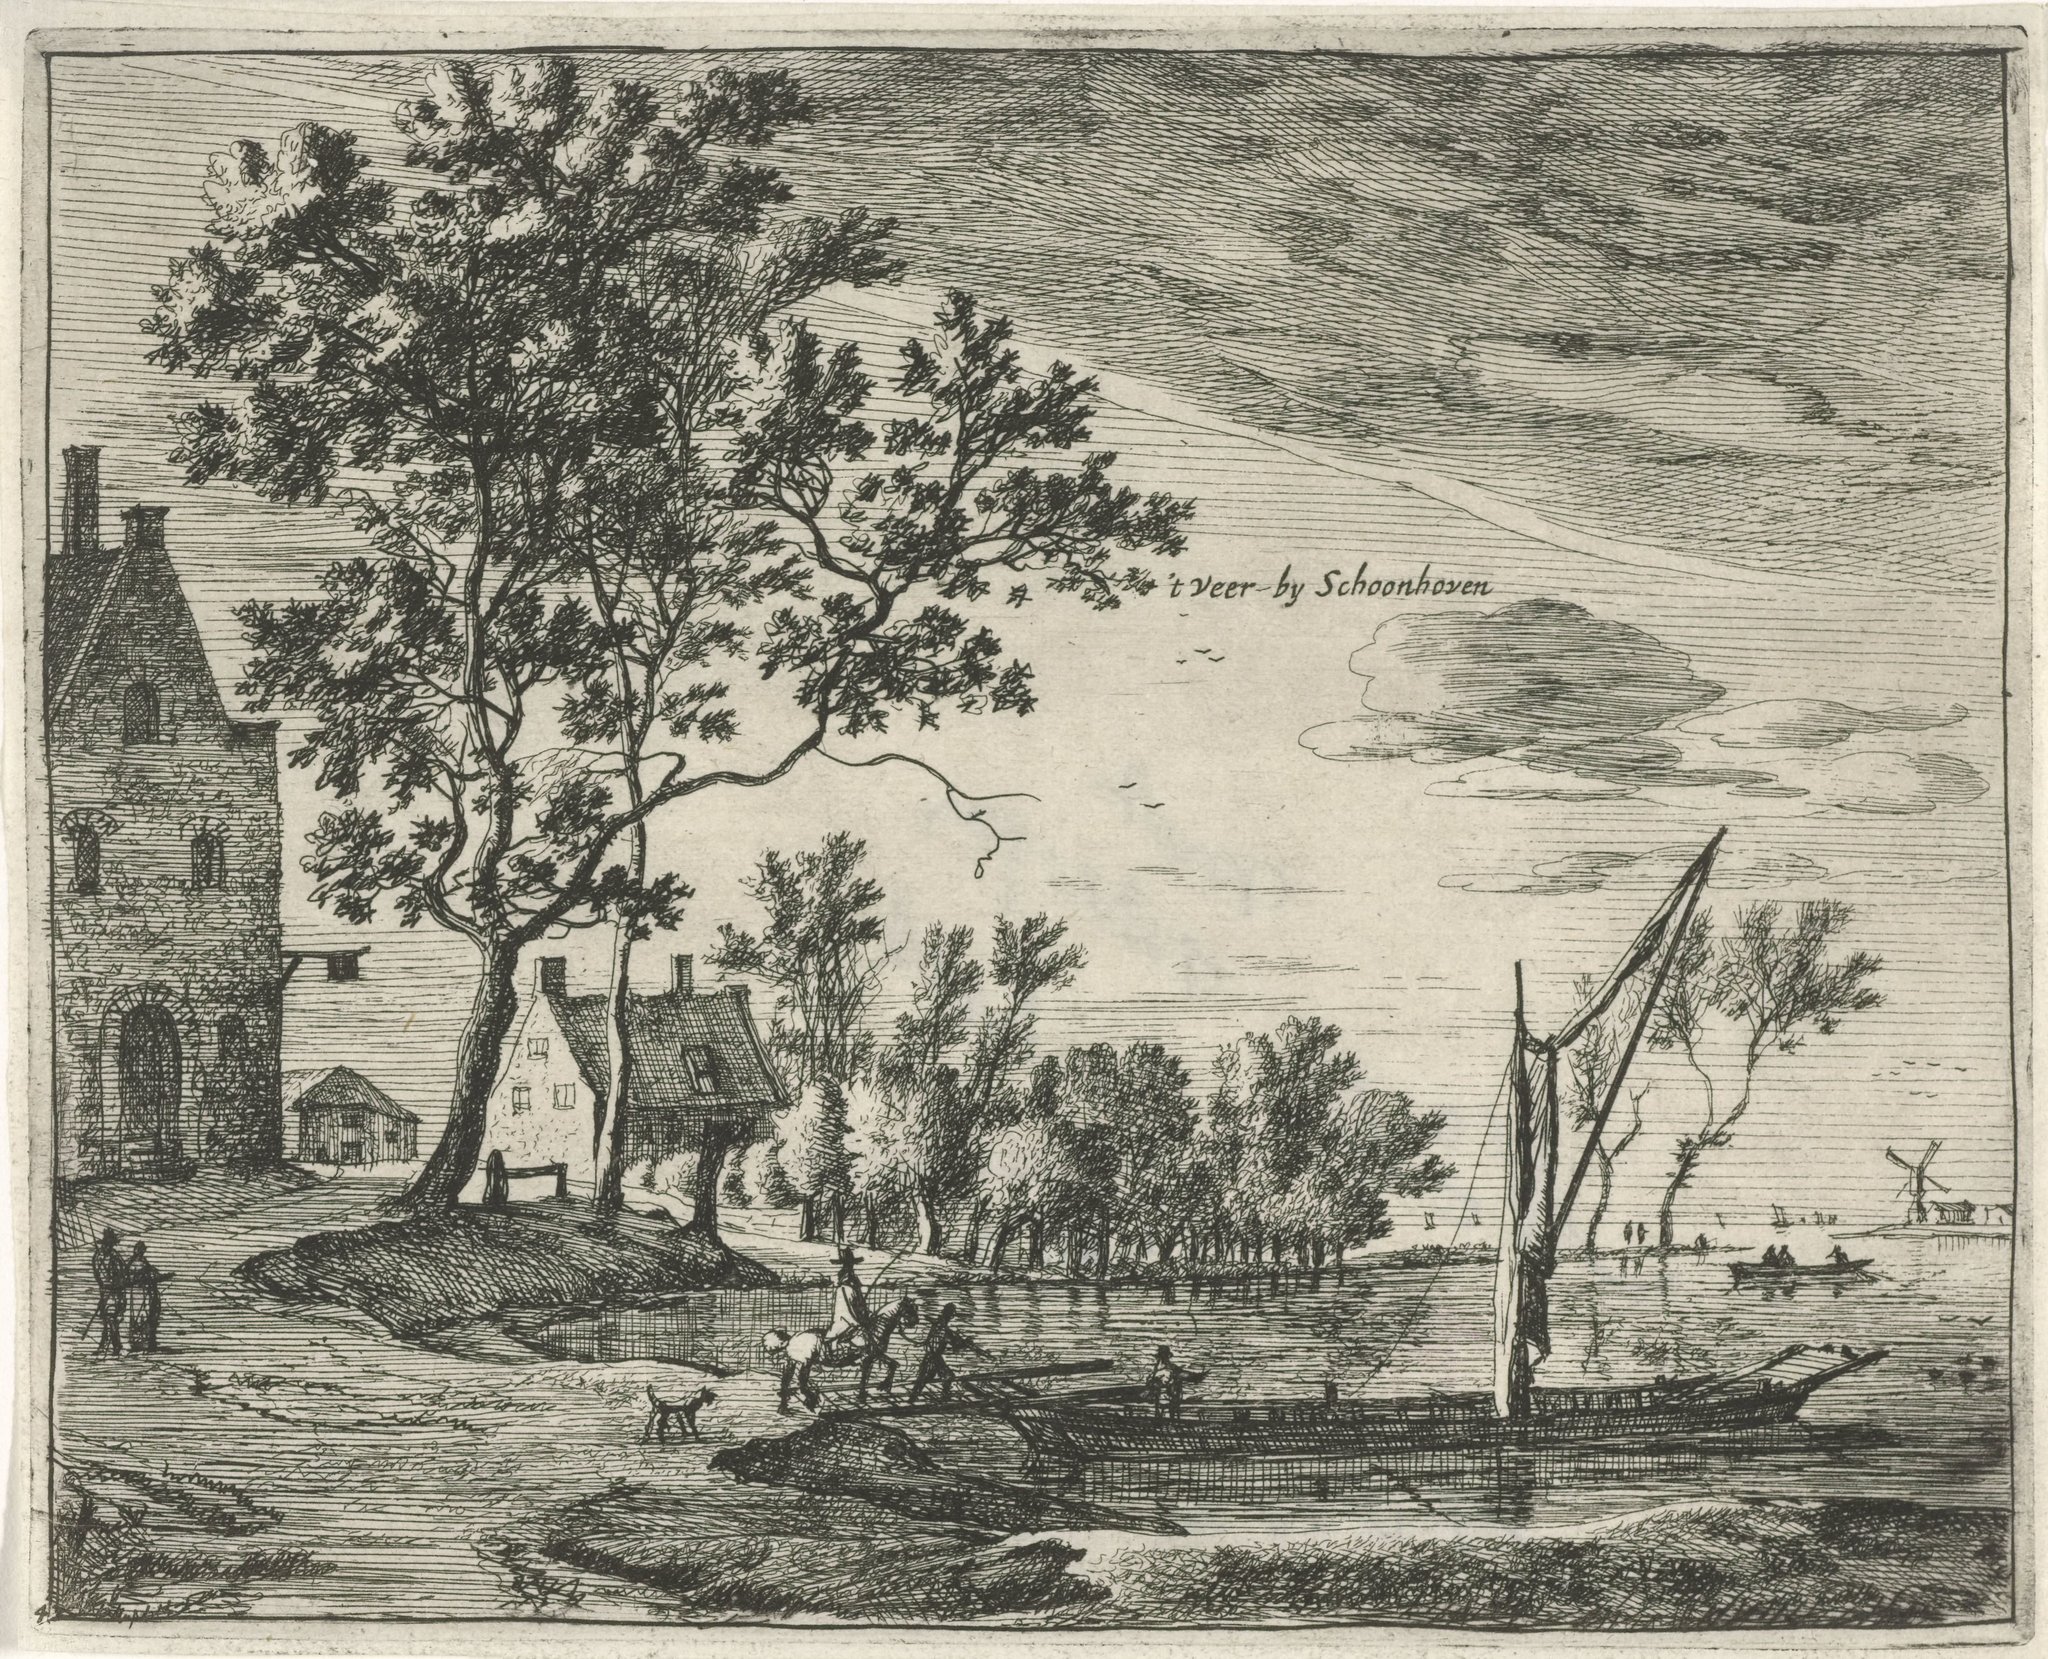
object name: print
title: Veer bij Schoonhoven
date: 1637-1677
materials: paper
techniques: engraving, etching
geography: amsterdam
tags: landscapes, ferry, windmill, hotel, hostelry, inn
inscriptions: collector's mark: Lugt 2228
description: Gezicht op het veer, over de rivier de Lek, bij Schoonhoven. Een ruiter, een man en een hond stappen op de veerpont, die hen mogelijk naar het buurtschap Gelkenes (aan de overzijde van de Lek) zal brengen. Links een herberg en op de achtergrond een molen.